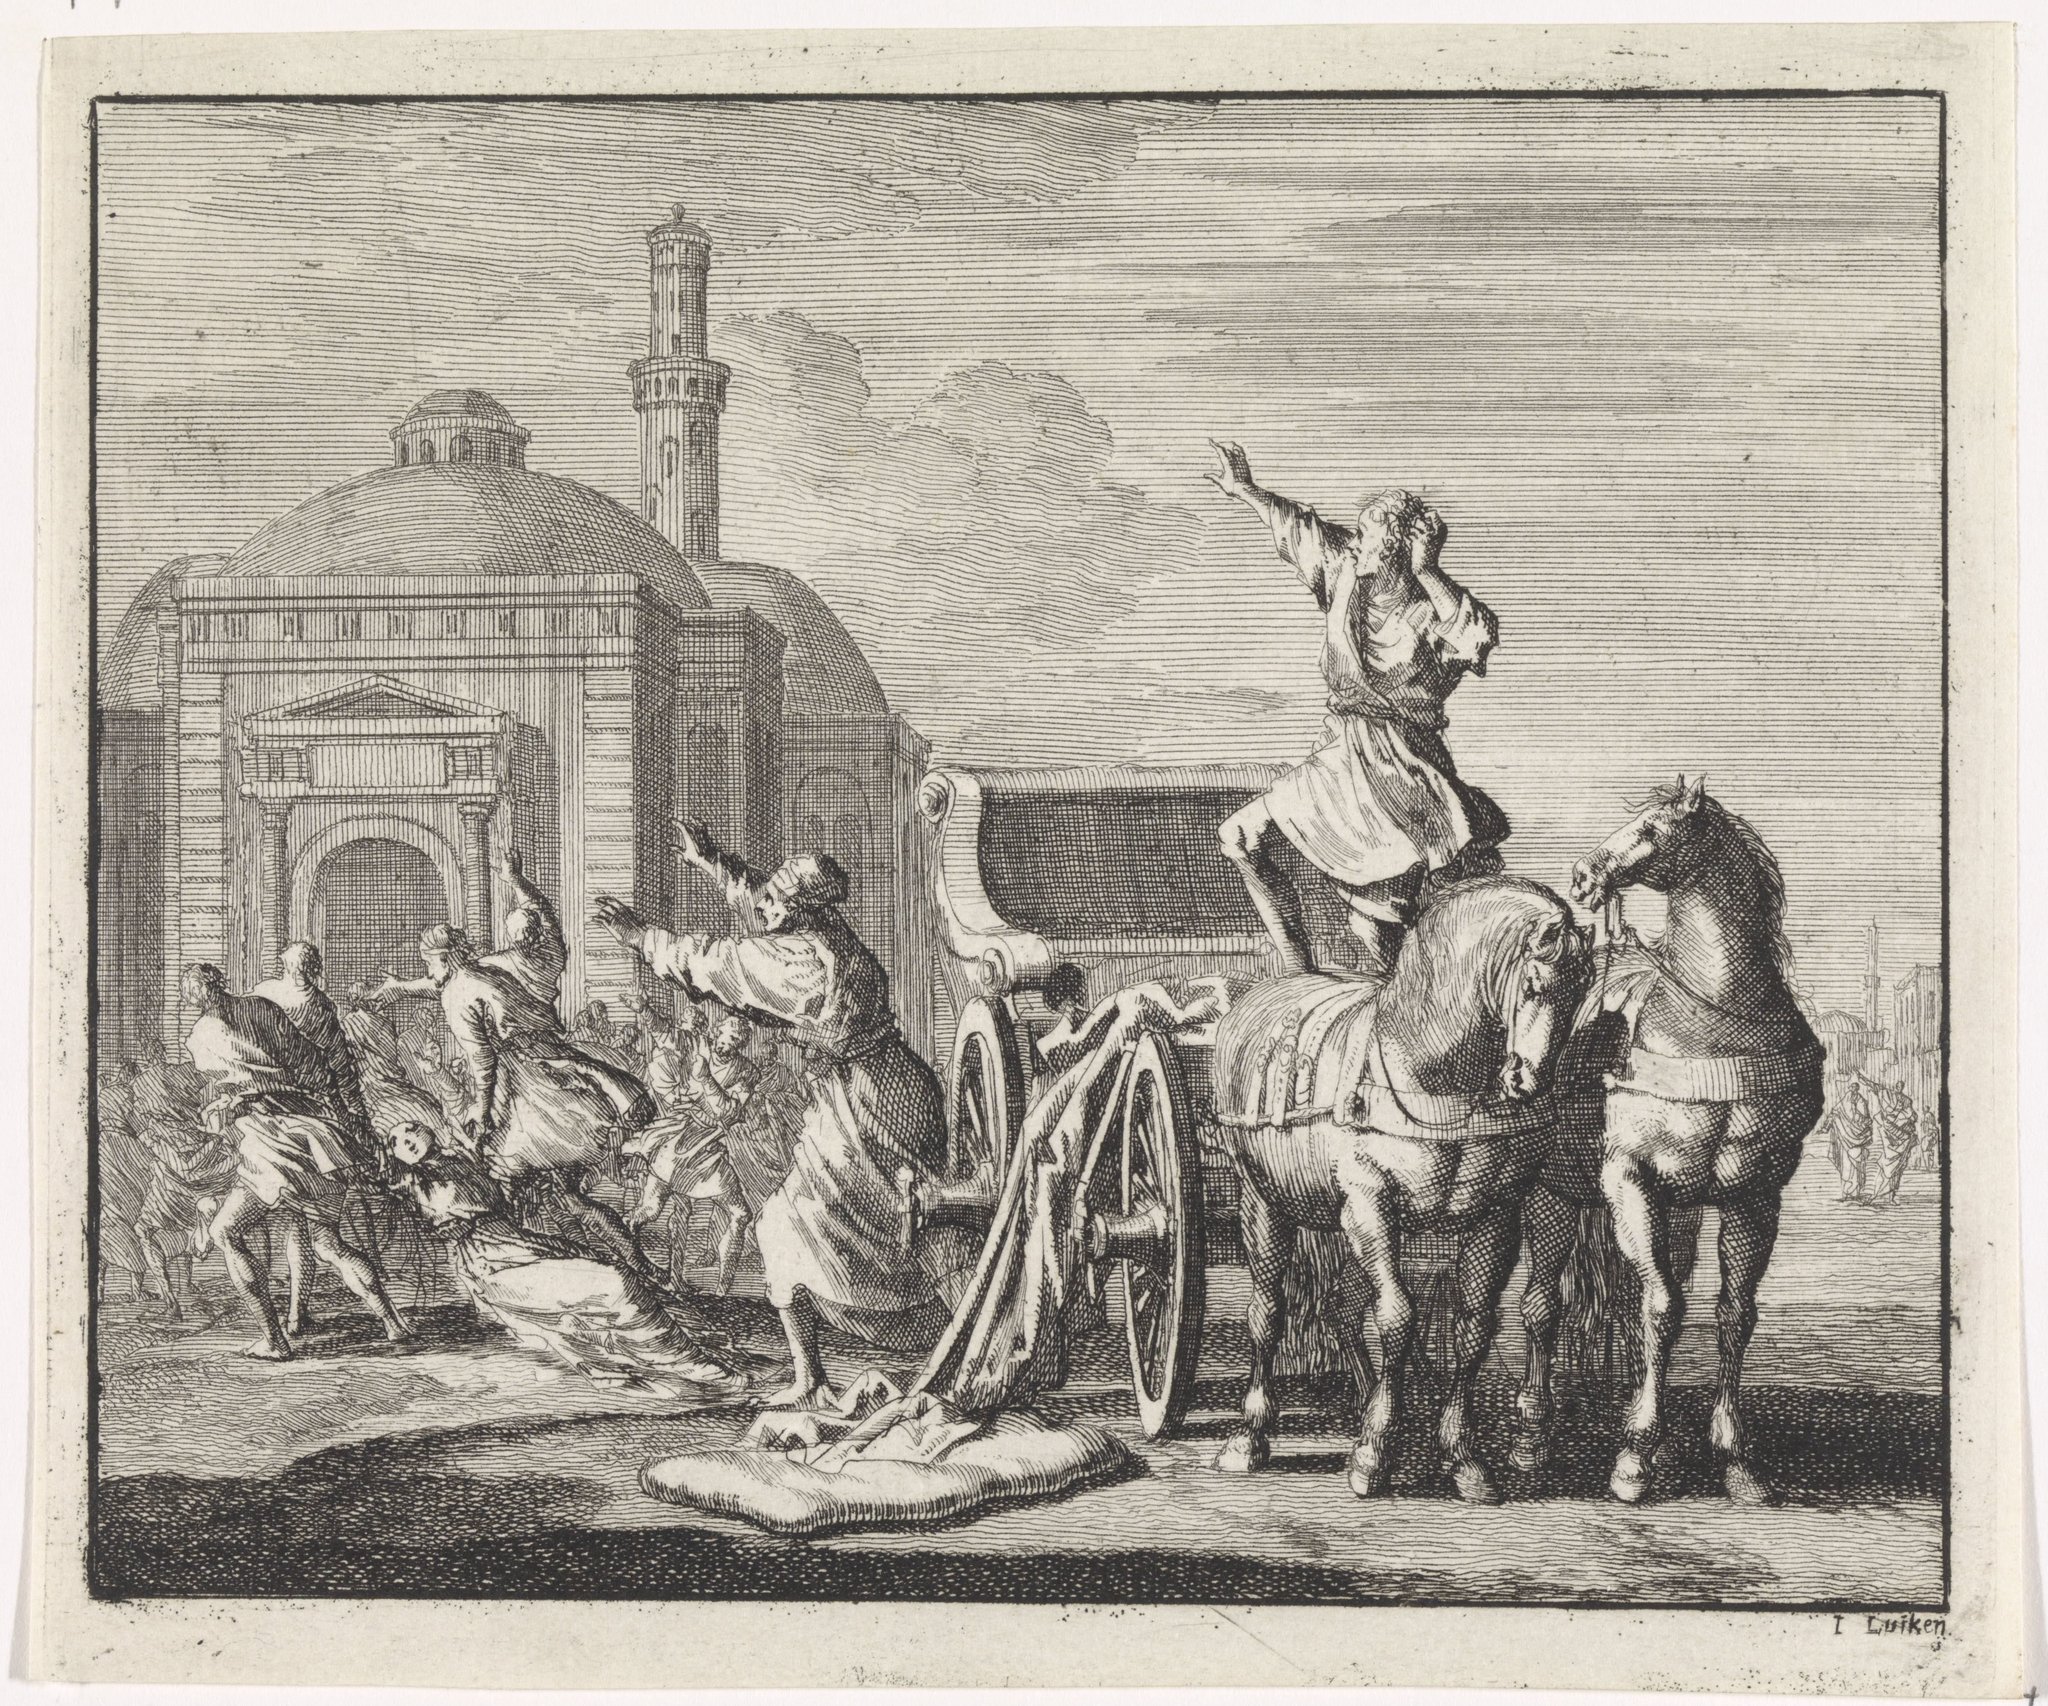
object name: print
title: Hypatia wordt door Christenen van haar koets getrokken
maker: jan luyken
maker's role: draughtsman, print maker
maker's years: 1649-1712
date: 1701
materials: paper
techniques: etching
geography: amsterdam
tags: the early christian churches, e.g. armenians, copts, syrians, abducting, four-wheeled vehicle drawn by two animals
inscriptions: collector's mark: Lugt 2228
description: Proefdruk van een boekillustratie Arnold, Godfried. Waare afbeelding der eerste christenen. Amsterdam: Jacobus van Hardenberg, Barent Visscher en Jacobus van Nieuweveen, 1700, dl. 2, p.